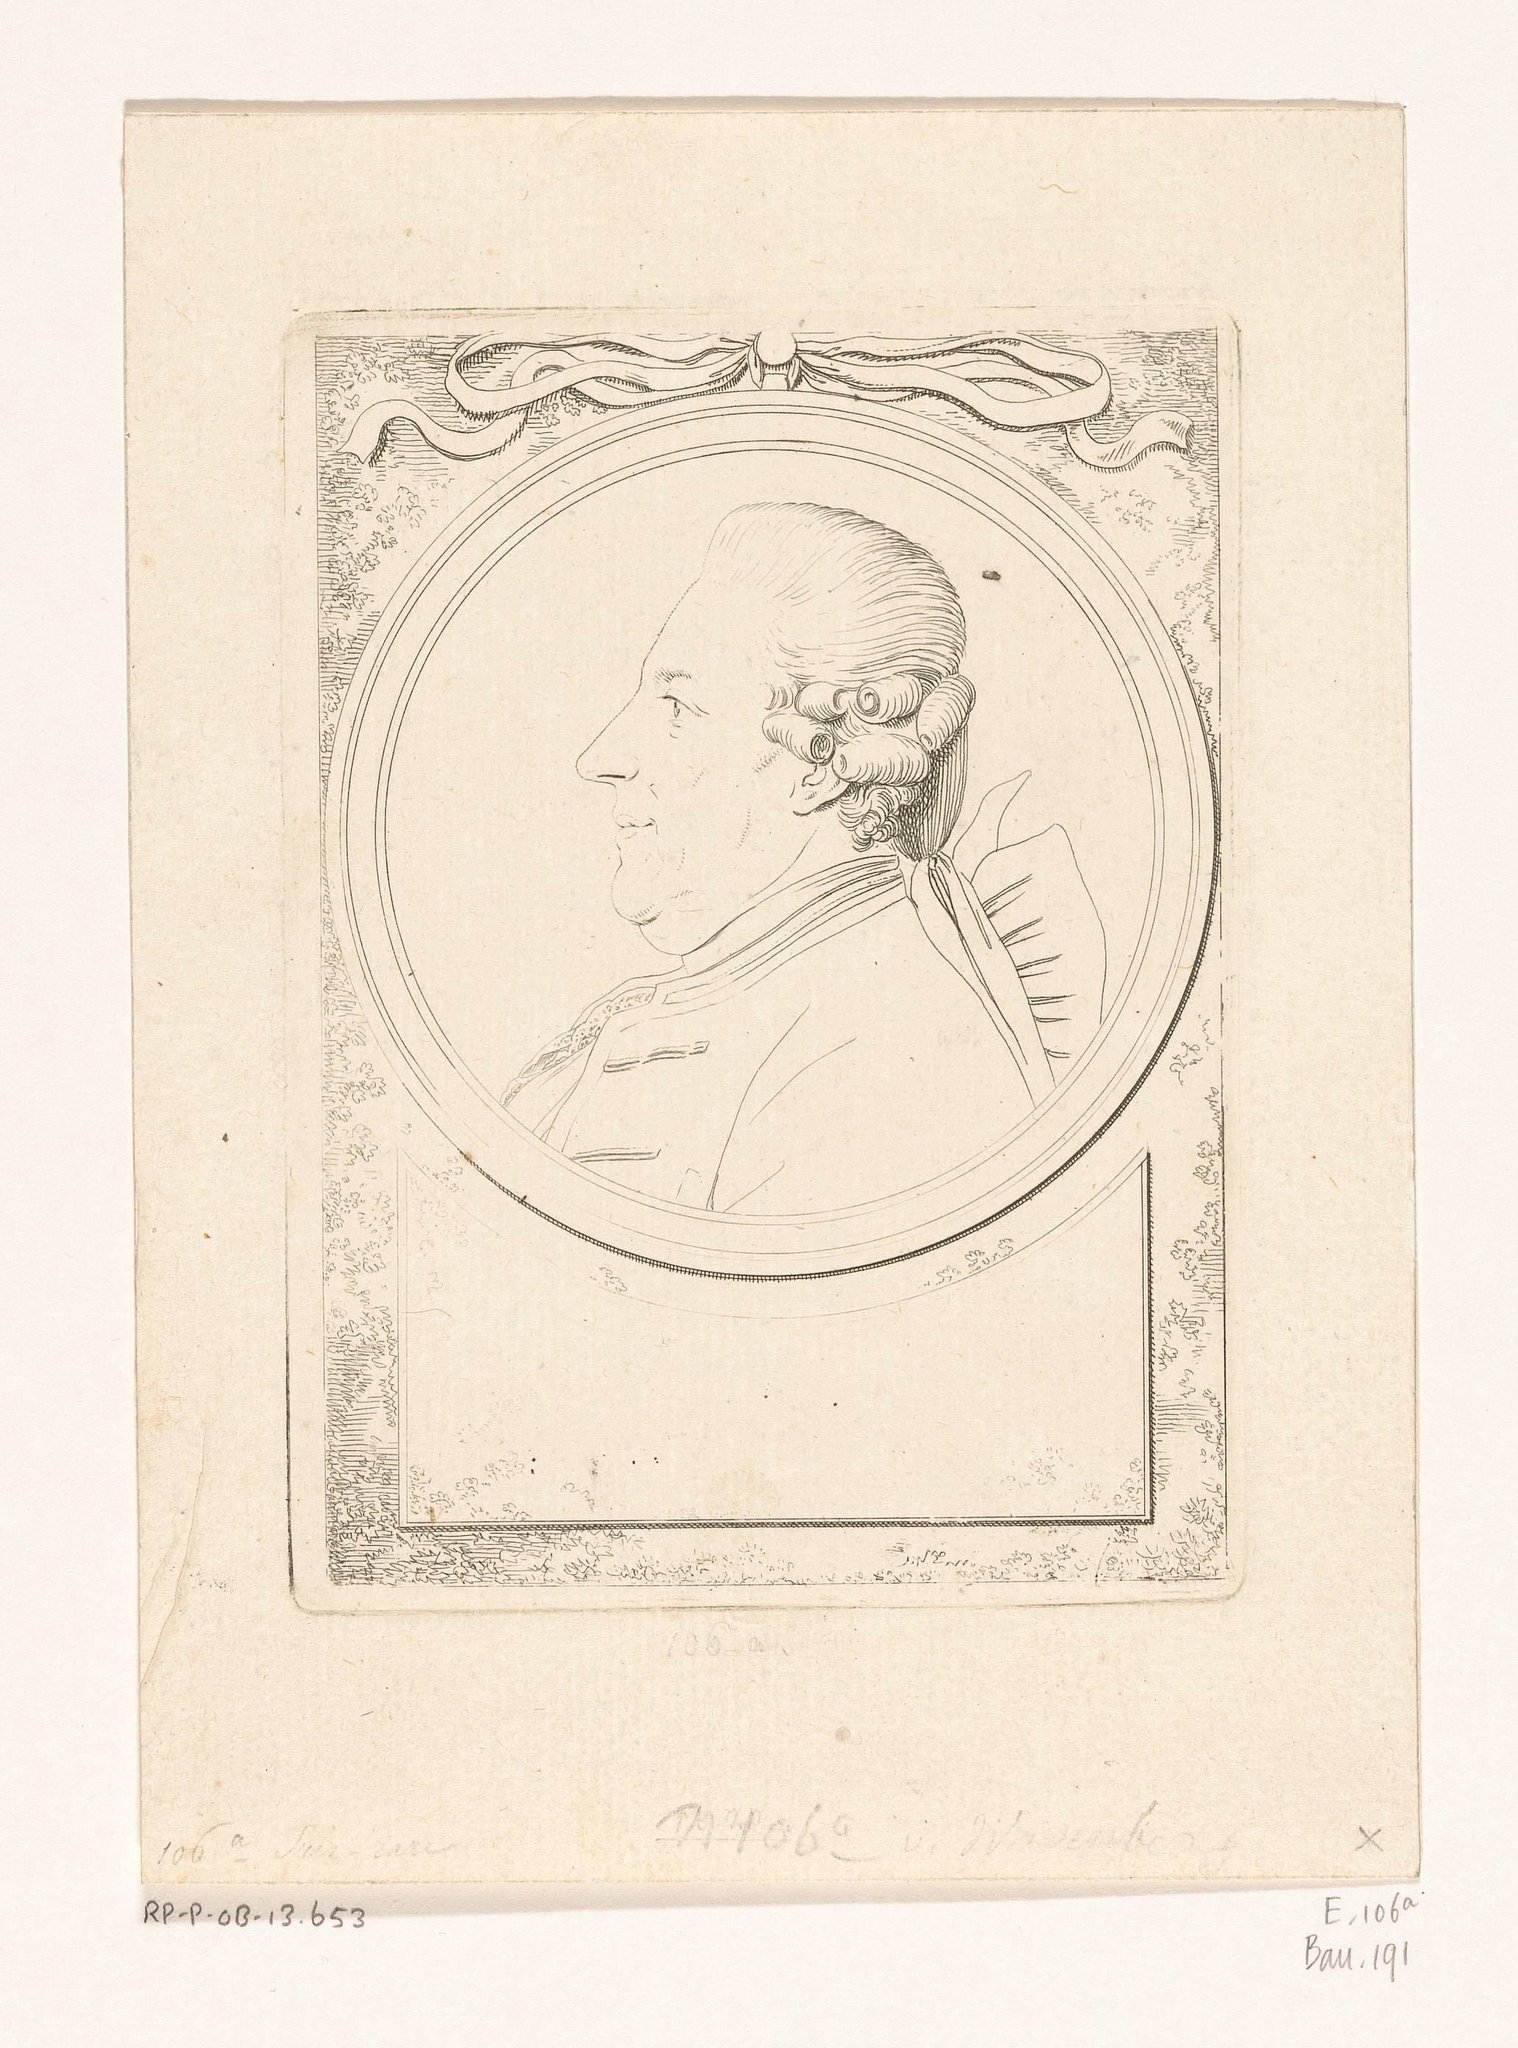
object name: print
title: Portret van Johann Anton Janson von Waasberghe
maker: daniel nikolaus chodowiecki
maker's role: draughtsman, print maker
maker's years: 1726-1801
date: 1773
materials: paper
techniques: etching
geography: berlin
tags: historical persons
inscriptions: collector's mark: Lugt 2228, inscription: ‘f 1.12’